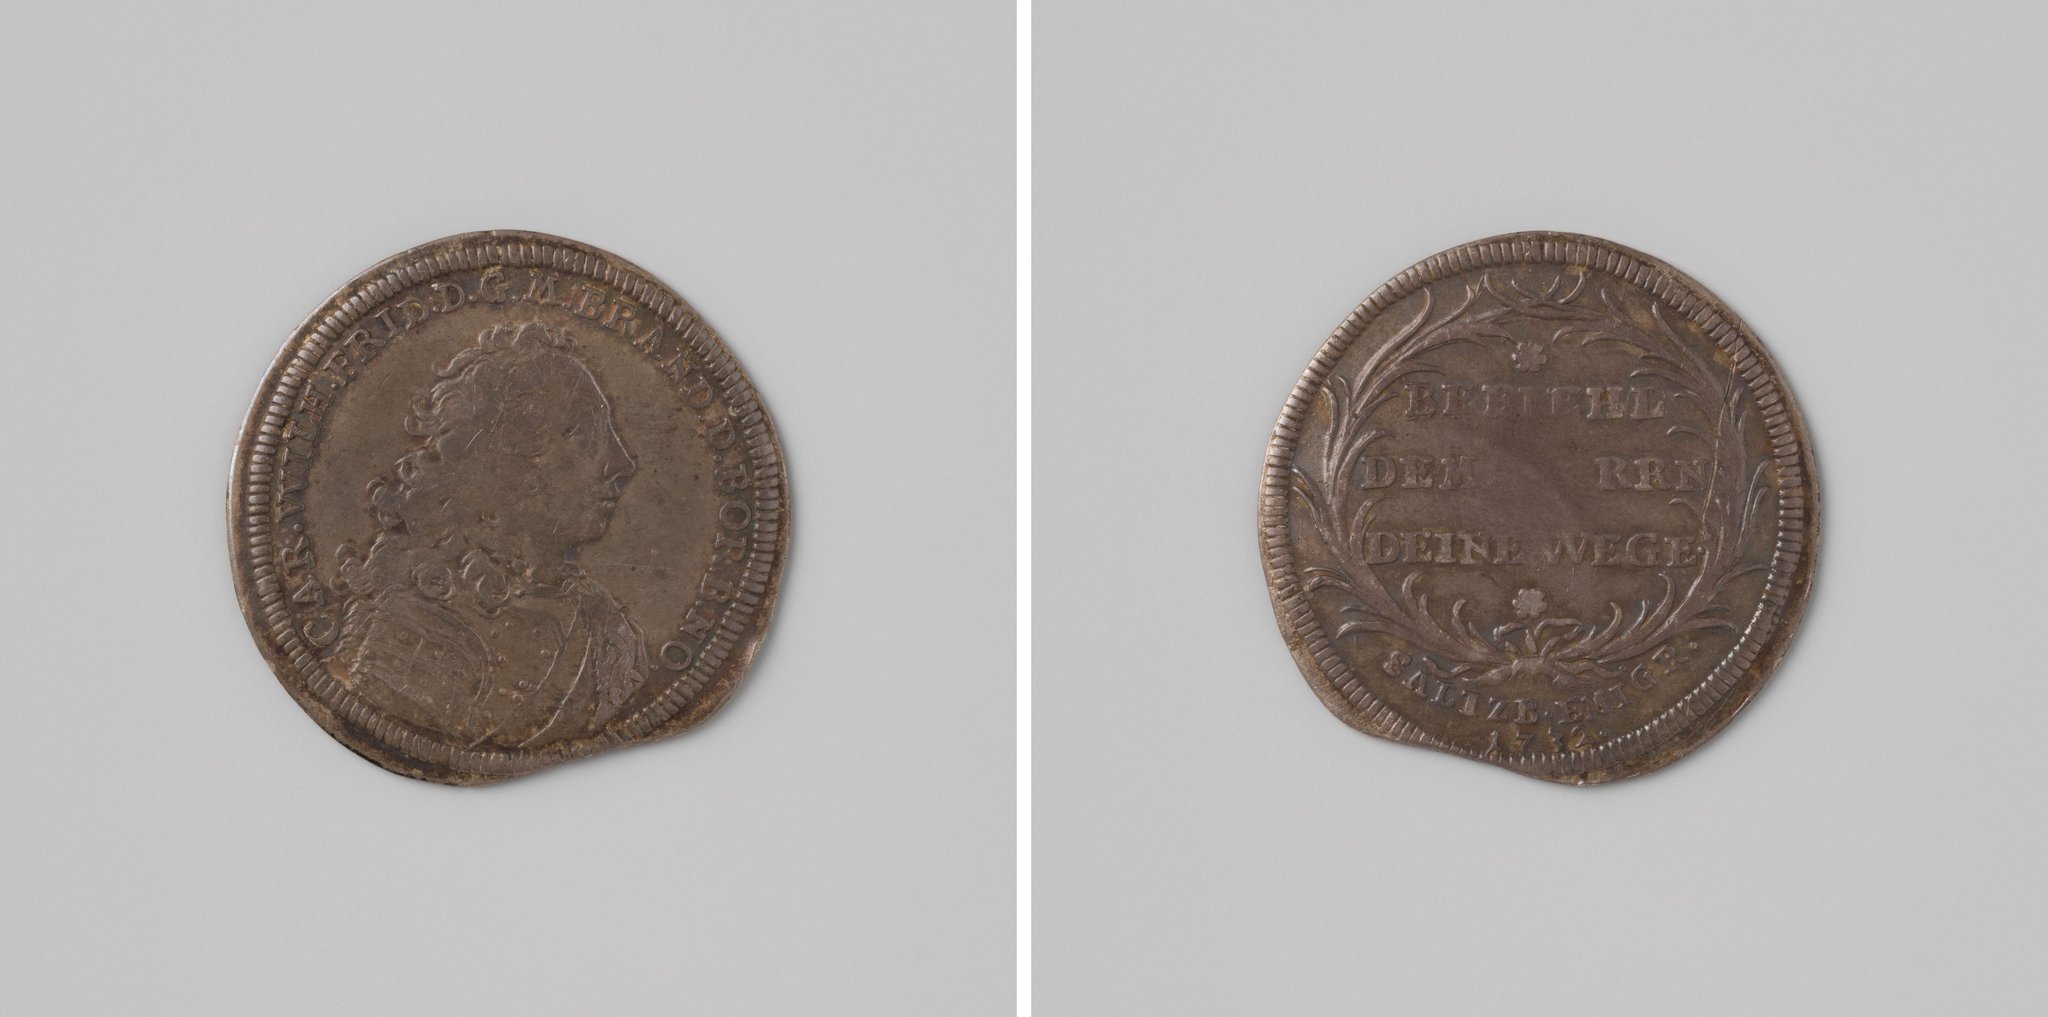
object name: history medal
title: Opname der Salzburger emigranten in Pruisen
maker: Anonymous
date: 1732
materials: silver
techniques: striking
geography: germany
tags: berlin, frederik willem i koning van pruisen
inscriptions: circumscription: ‘CAR.WILH.FRID.D.G.M.BRAND.D.BOR.B.NO.’, inscription: ‘BEFIEHL DEM HERRN DEINE WEGE’, inscription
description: Zilveren penning. Voorzijde: borststuk man binnen omschrift. Keerzijde: opschrift binnen takken; afsnede: opschrift